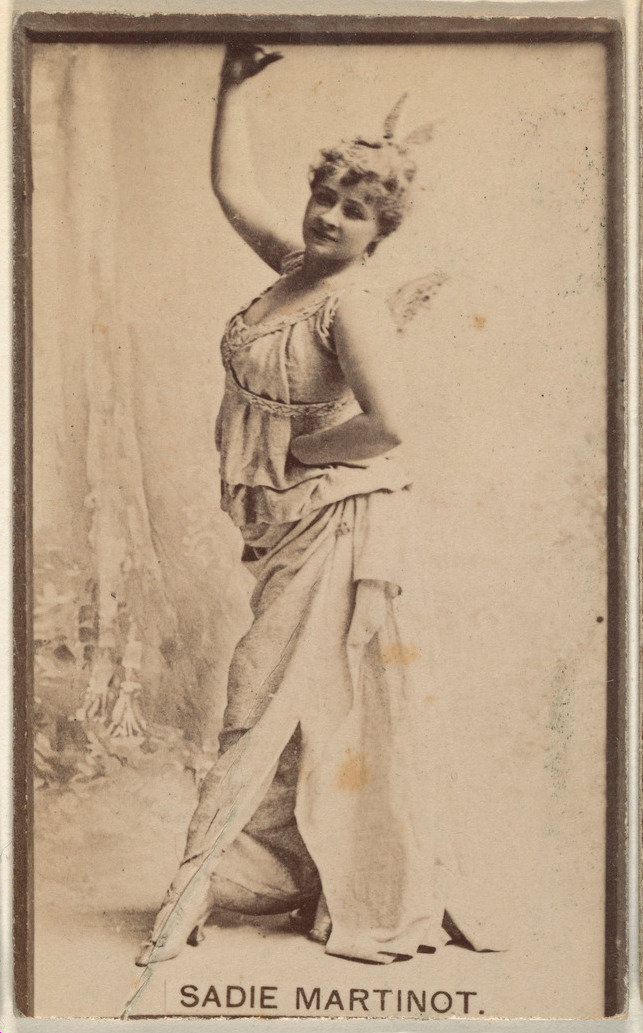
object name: photograph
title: Sadie Martinot, from the Actresses series (N668)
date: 1888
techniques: albumen silver print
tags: portraits,women,actresses